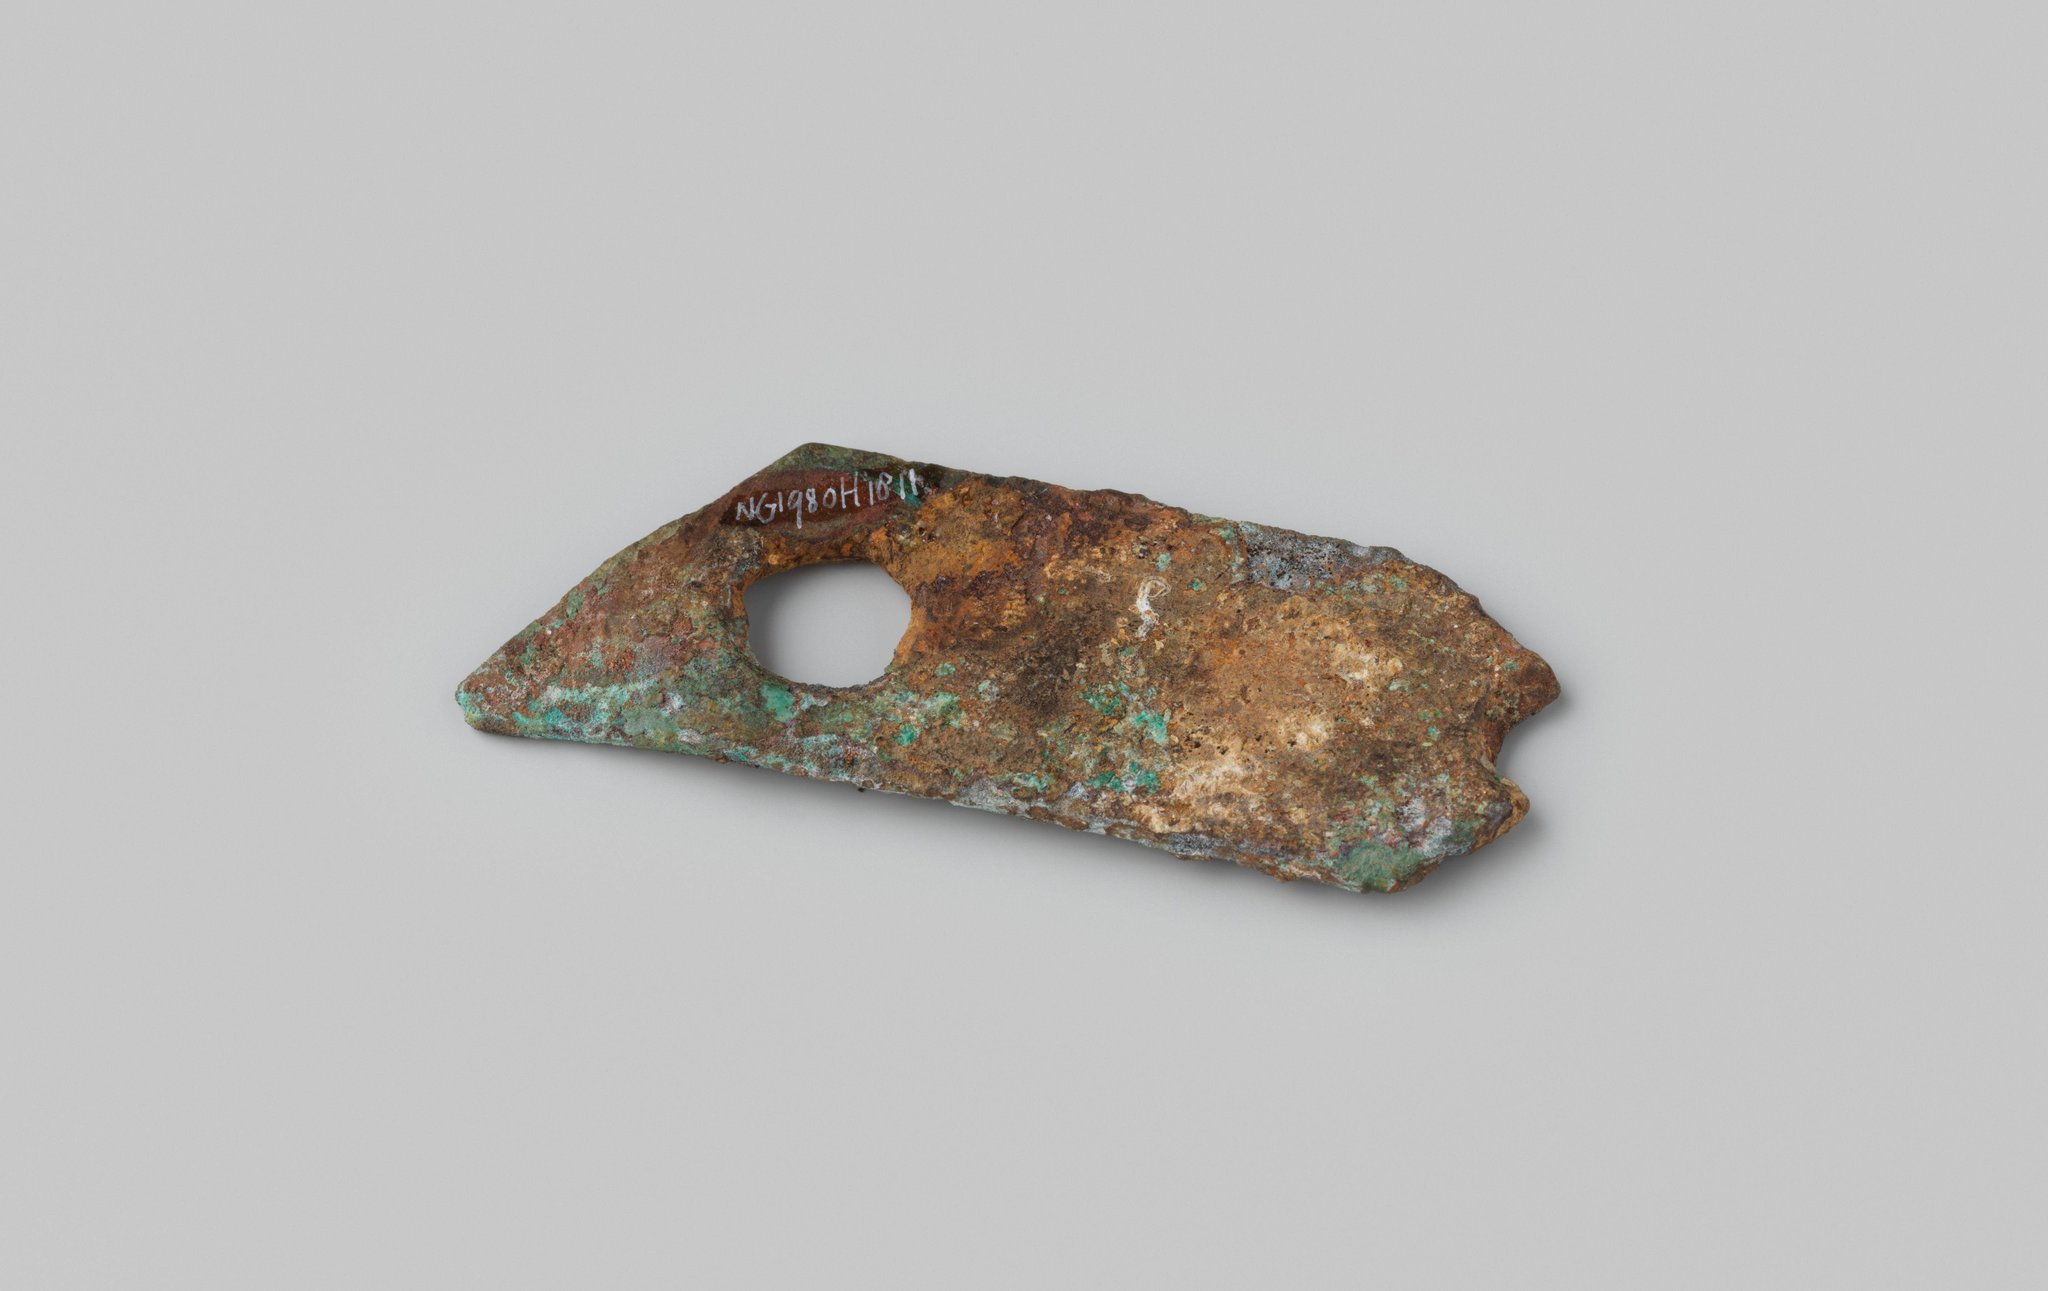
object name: part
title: Onderdeel of hulpstuk afkomstig uit het wrak van de Oost-Indiëvaarder Hollandia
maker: Anonymous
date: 1700-1743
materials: copper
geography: netherlands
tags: verenigde oostindische compagnie, hollandia (schip)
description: Strip-shaped fitting; fragm, id. 80H1737.